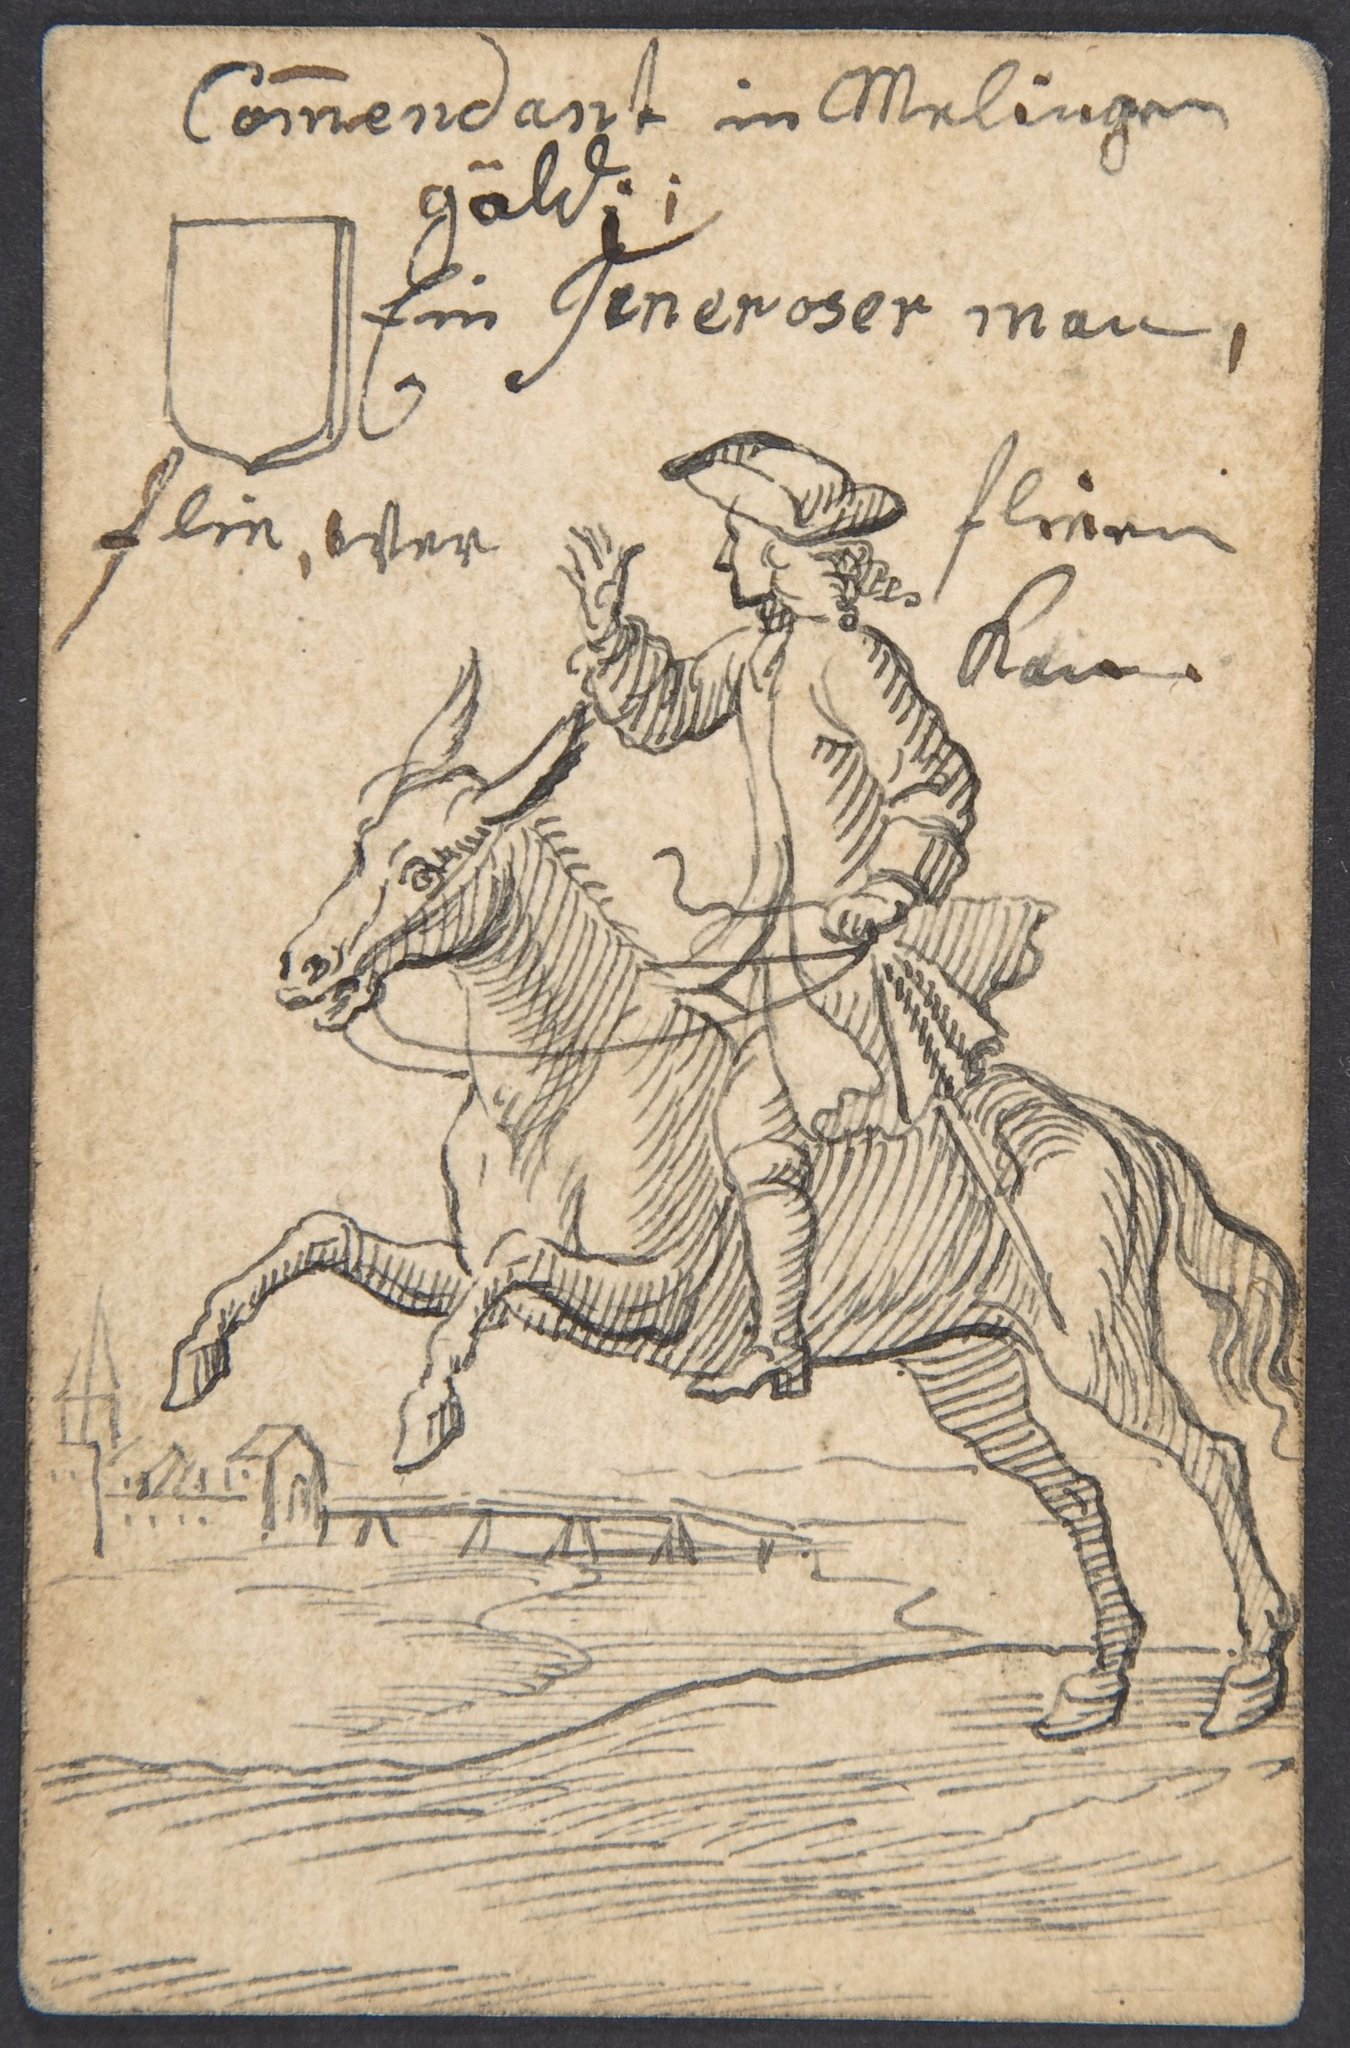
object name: drawing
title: Shield Knave: A Horseman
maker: johannes brandenberg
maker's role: artist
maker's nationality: swiss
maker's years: 1661-1729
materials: ink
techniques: pen, woodcut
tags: men,horses